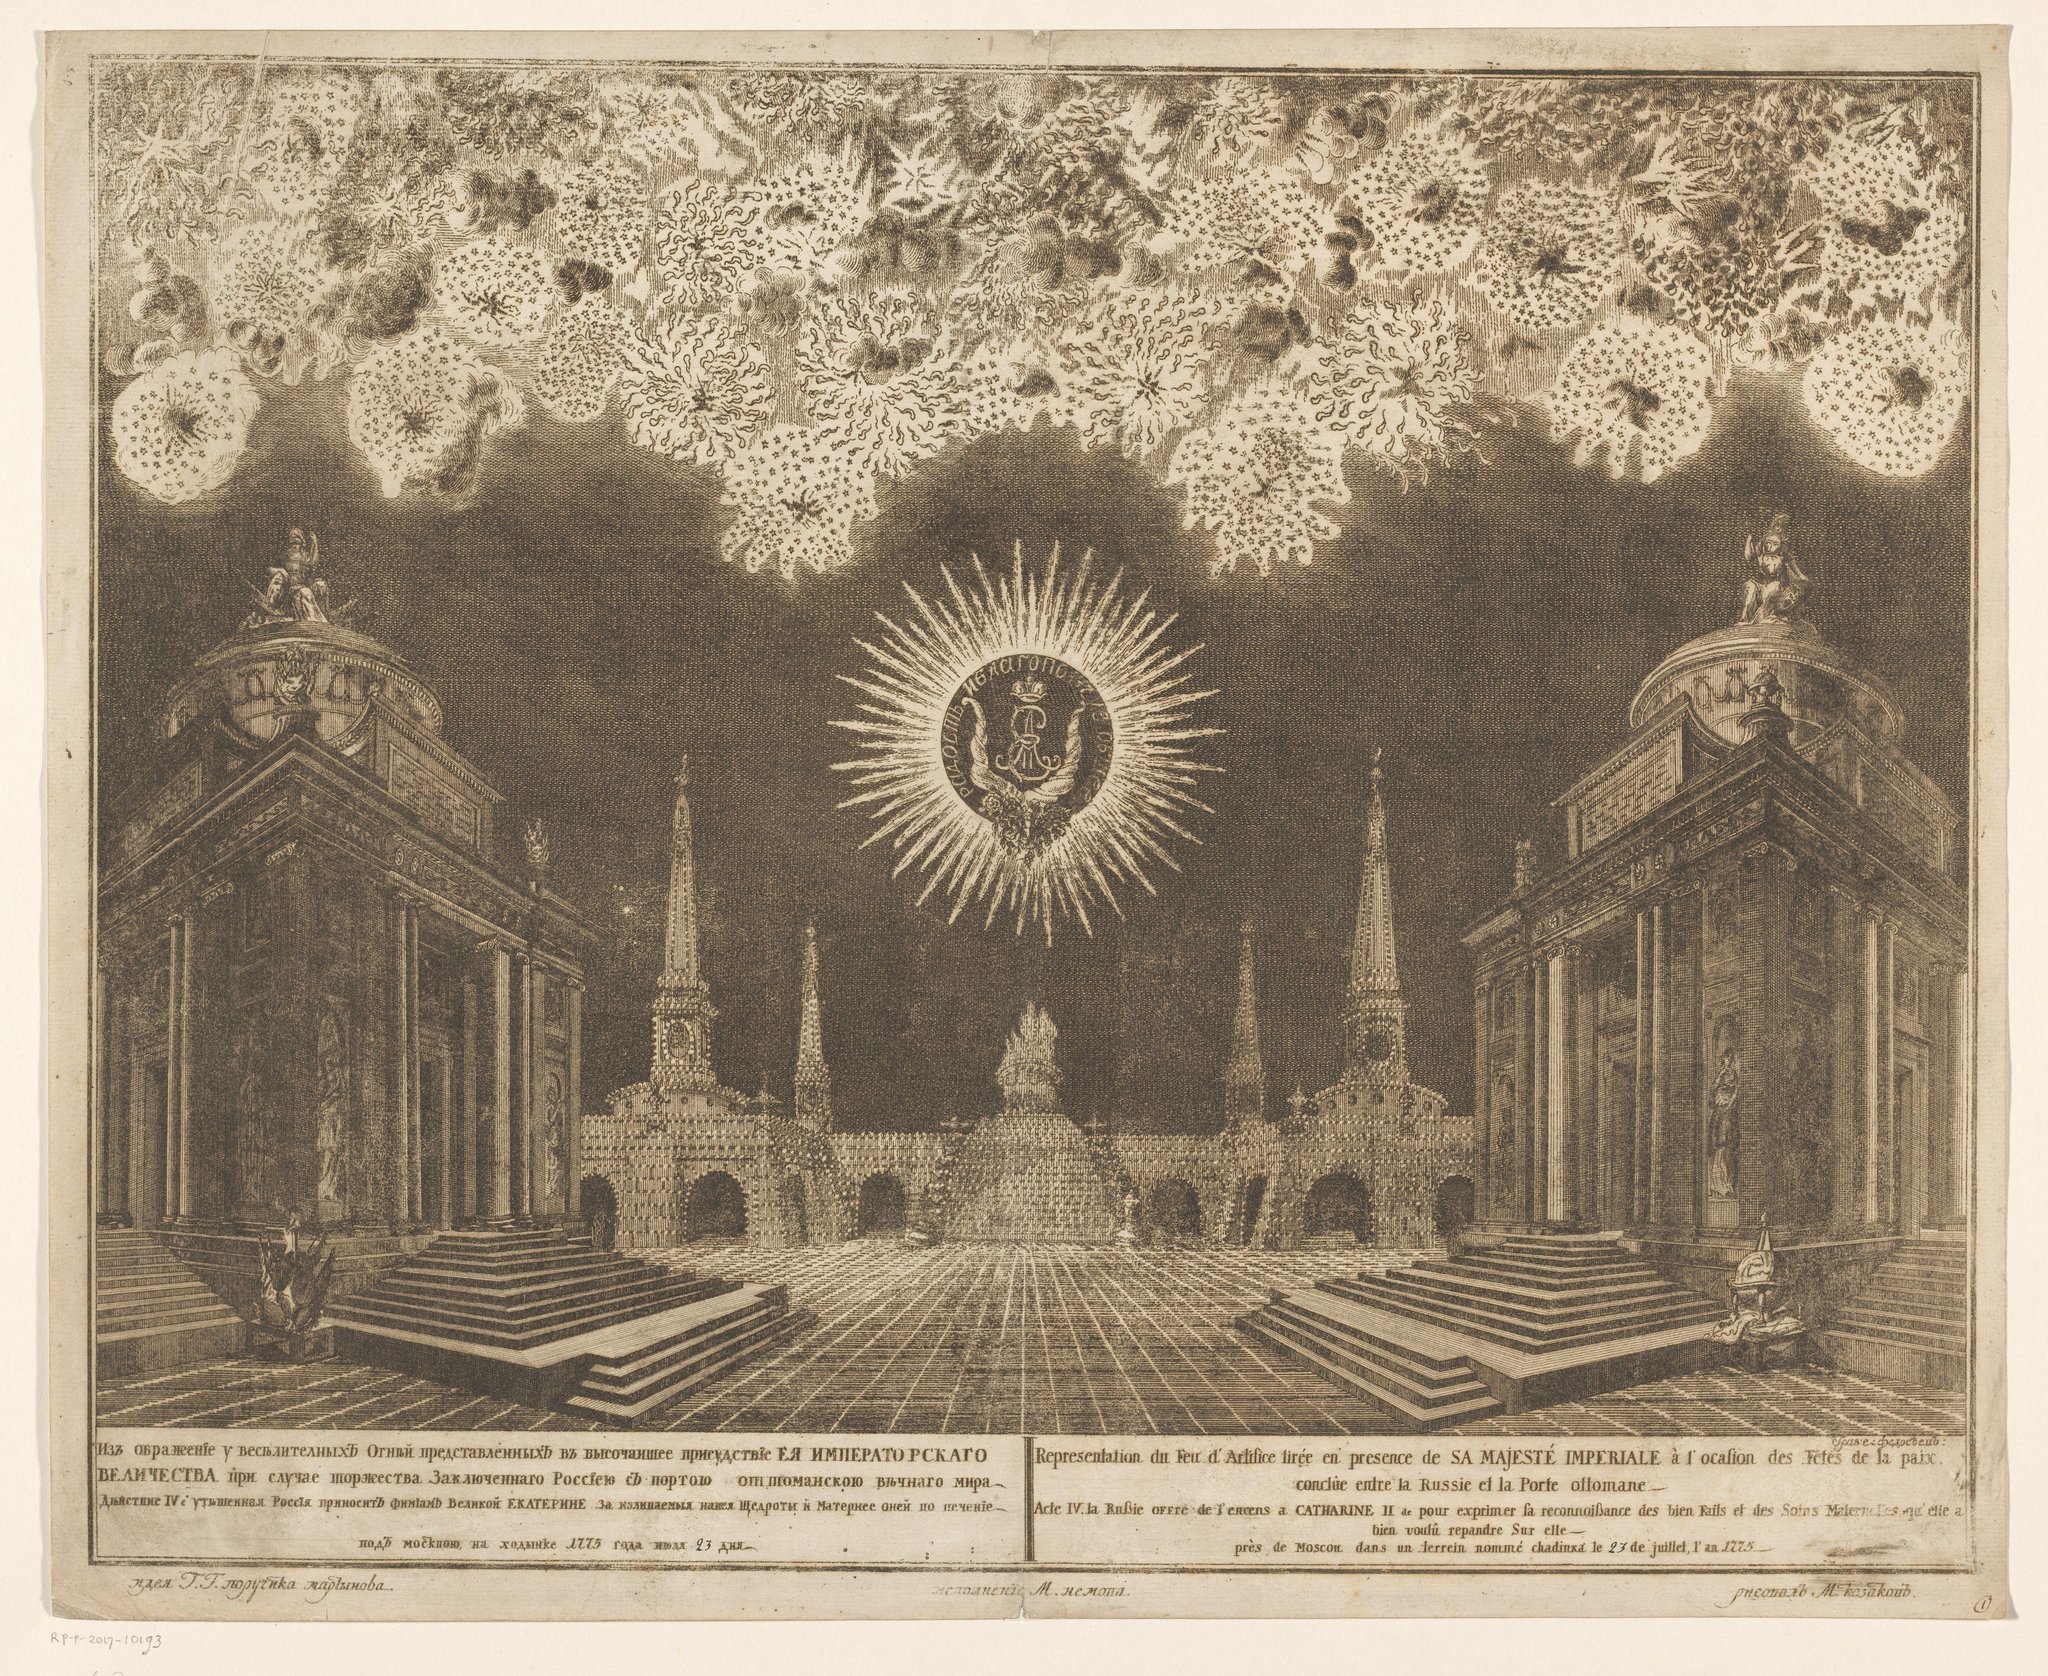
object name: print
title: Vuurwerk in Moskou bij de viering van het einde van de Russisch-Turkse Oorlog, 1775 (Acte IV)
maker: emelian alekseevič fedoseev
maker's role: print maker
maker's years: 1745-1778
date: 1775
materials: paper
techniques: etching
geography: russia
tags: catharina de grote, bonfire, fire-works, festivities on events of national importance (+ illumination, fire-works ~ festive activities)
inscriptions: collector's mark: Lugt 2228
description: Vuurwerk in Moskou bij de viering op 23 juli 1775 van het einde van de Russisch-Turkse Oorlog met het sluiten van Verdrag van Küçük Kaynarca. Vuurwerk afgestoken in aanwezigheid van tsarina Catharina de Grote. Onderdeel van een serie van drie platen met onderschriften in het Russisch en Frans.